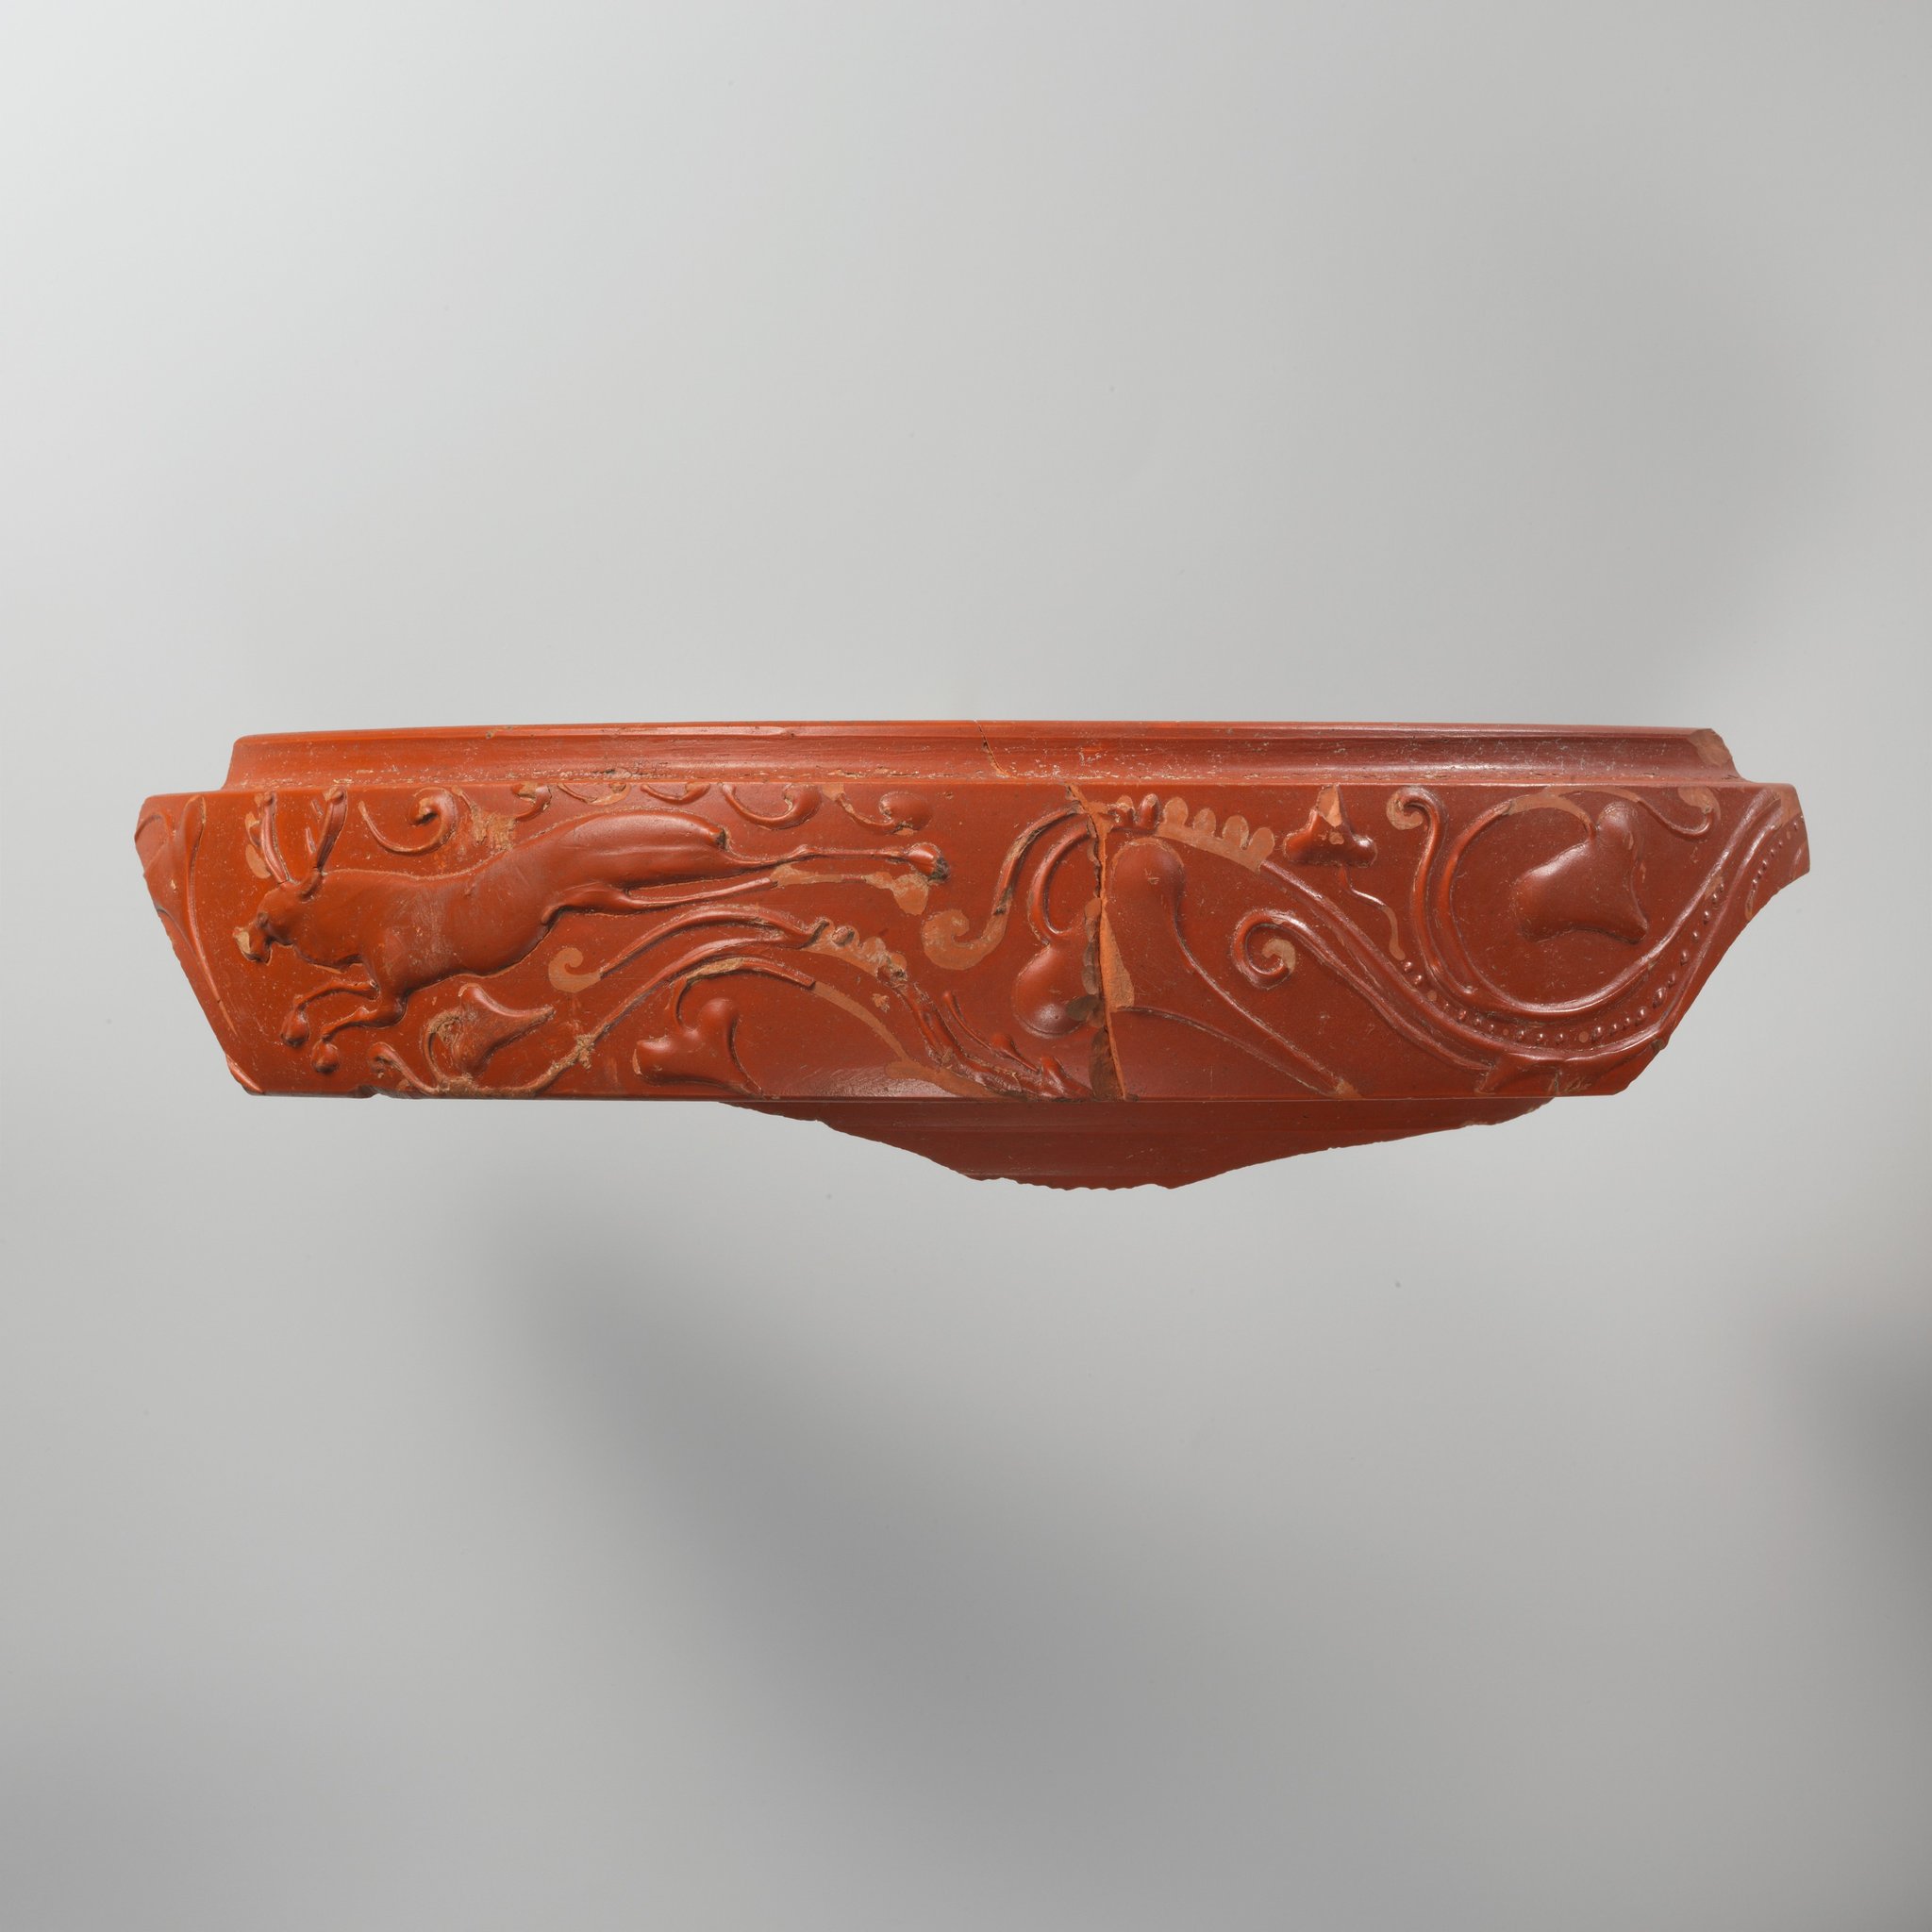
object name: mortarium fragment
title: Terracotta mortarium fragment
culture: roman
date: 167-200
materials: terracotta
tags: animals